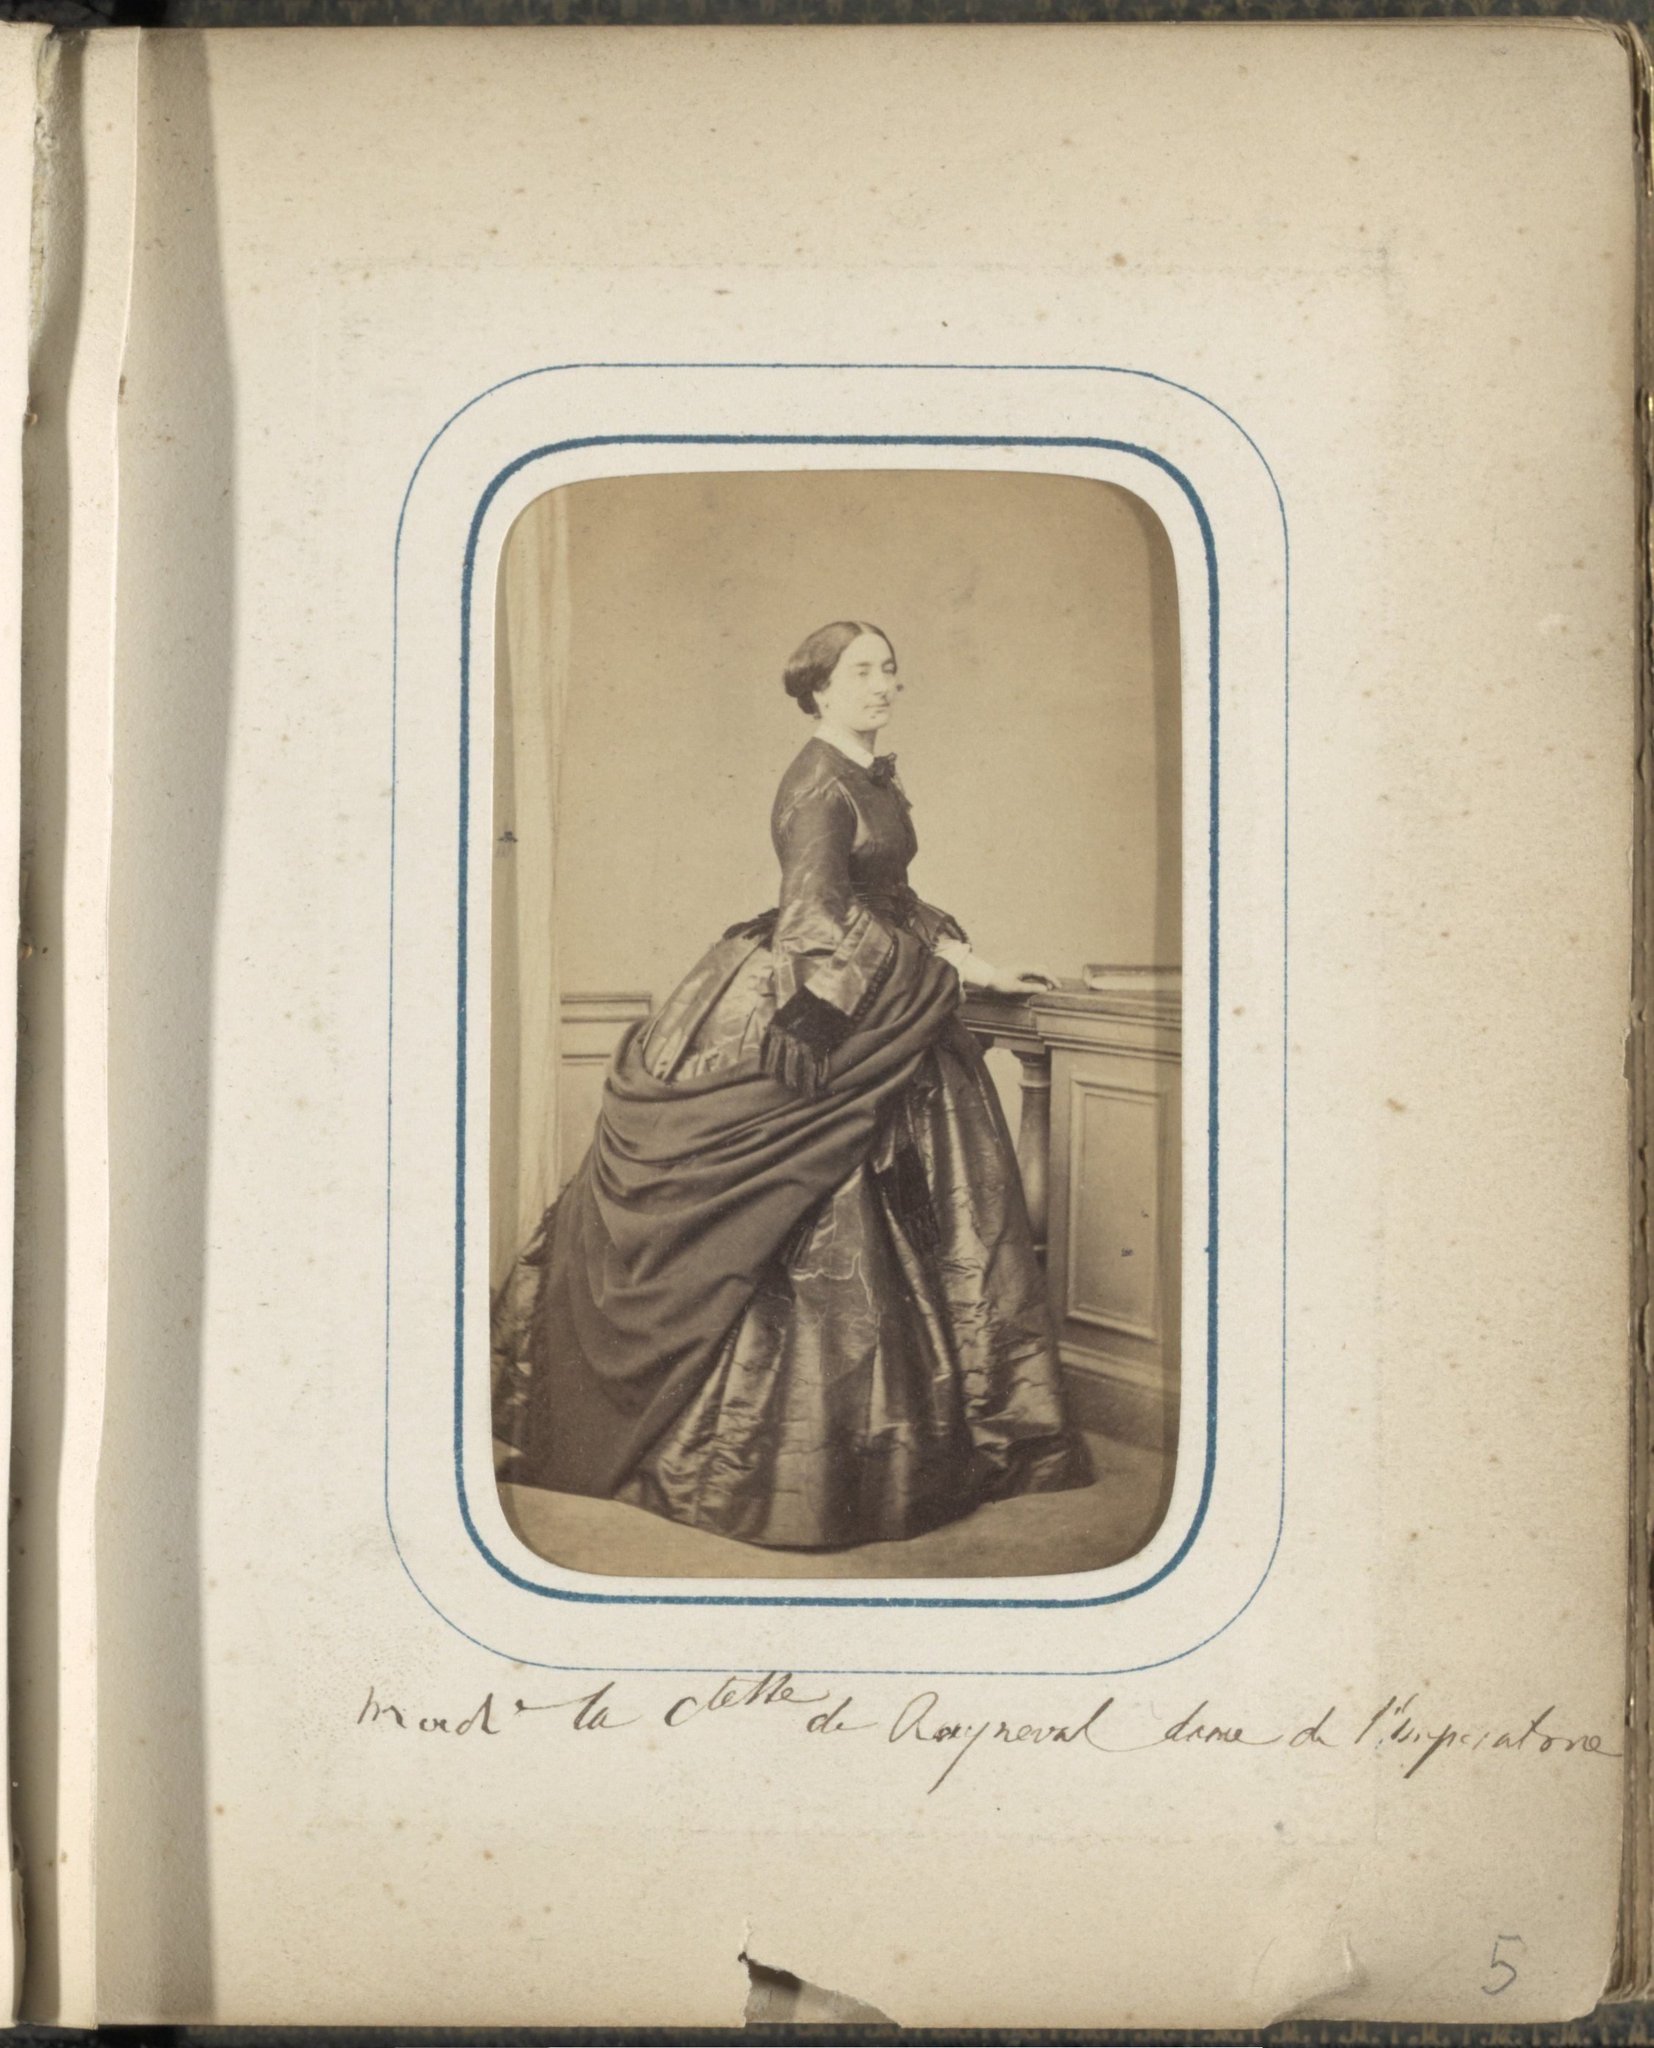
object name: carte de visite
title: Portret van de gravin van Rayneval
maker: françois marie louis franck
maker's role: fotograaf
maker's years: 1816-1906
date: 1860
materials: cardboard, paper, photographic support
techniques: albumen print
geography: annecy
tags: studio requisites ~ photographer, historical persons, styles of hairdress - aa - ~ women, dress, gown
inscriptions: name: ‘Mad. la ctesse de Rayneval dame de [...]’, address: ‘Annecy’, date: ‘le 30 Aout 1860’, address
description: Onderdeel van Fotoalbum met 24 cartes-de-visite van Franse personen.